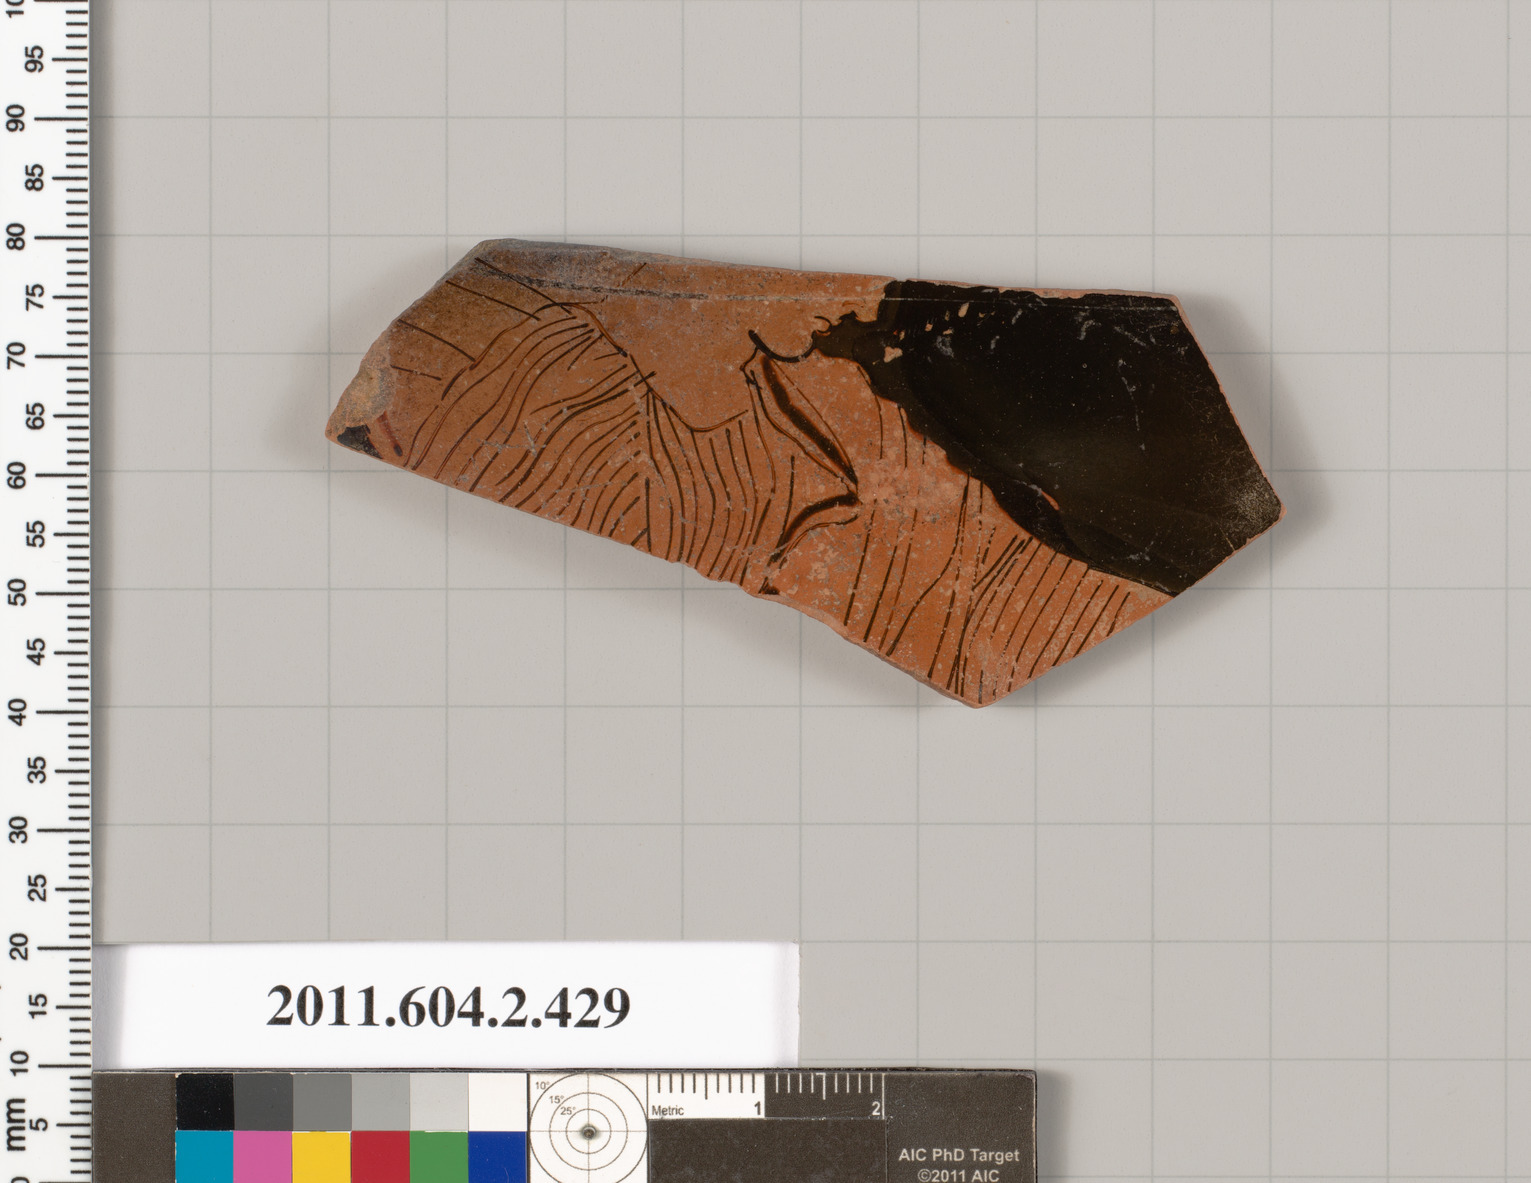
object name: column krater fragment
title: Terracotta fragment of a column-krater (bowl for mixing wine and water)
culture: greek, attic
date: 460-440 BCE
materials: terracotta